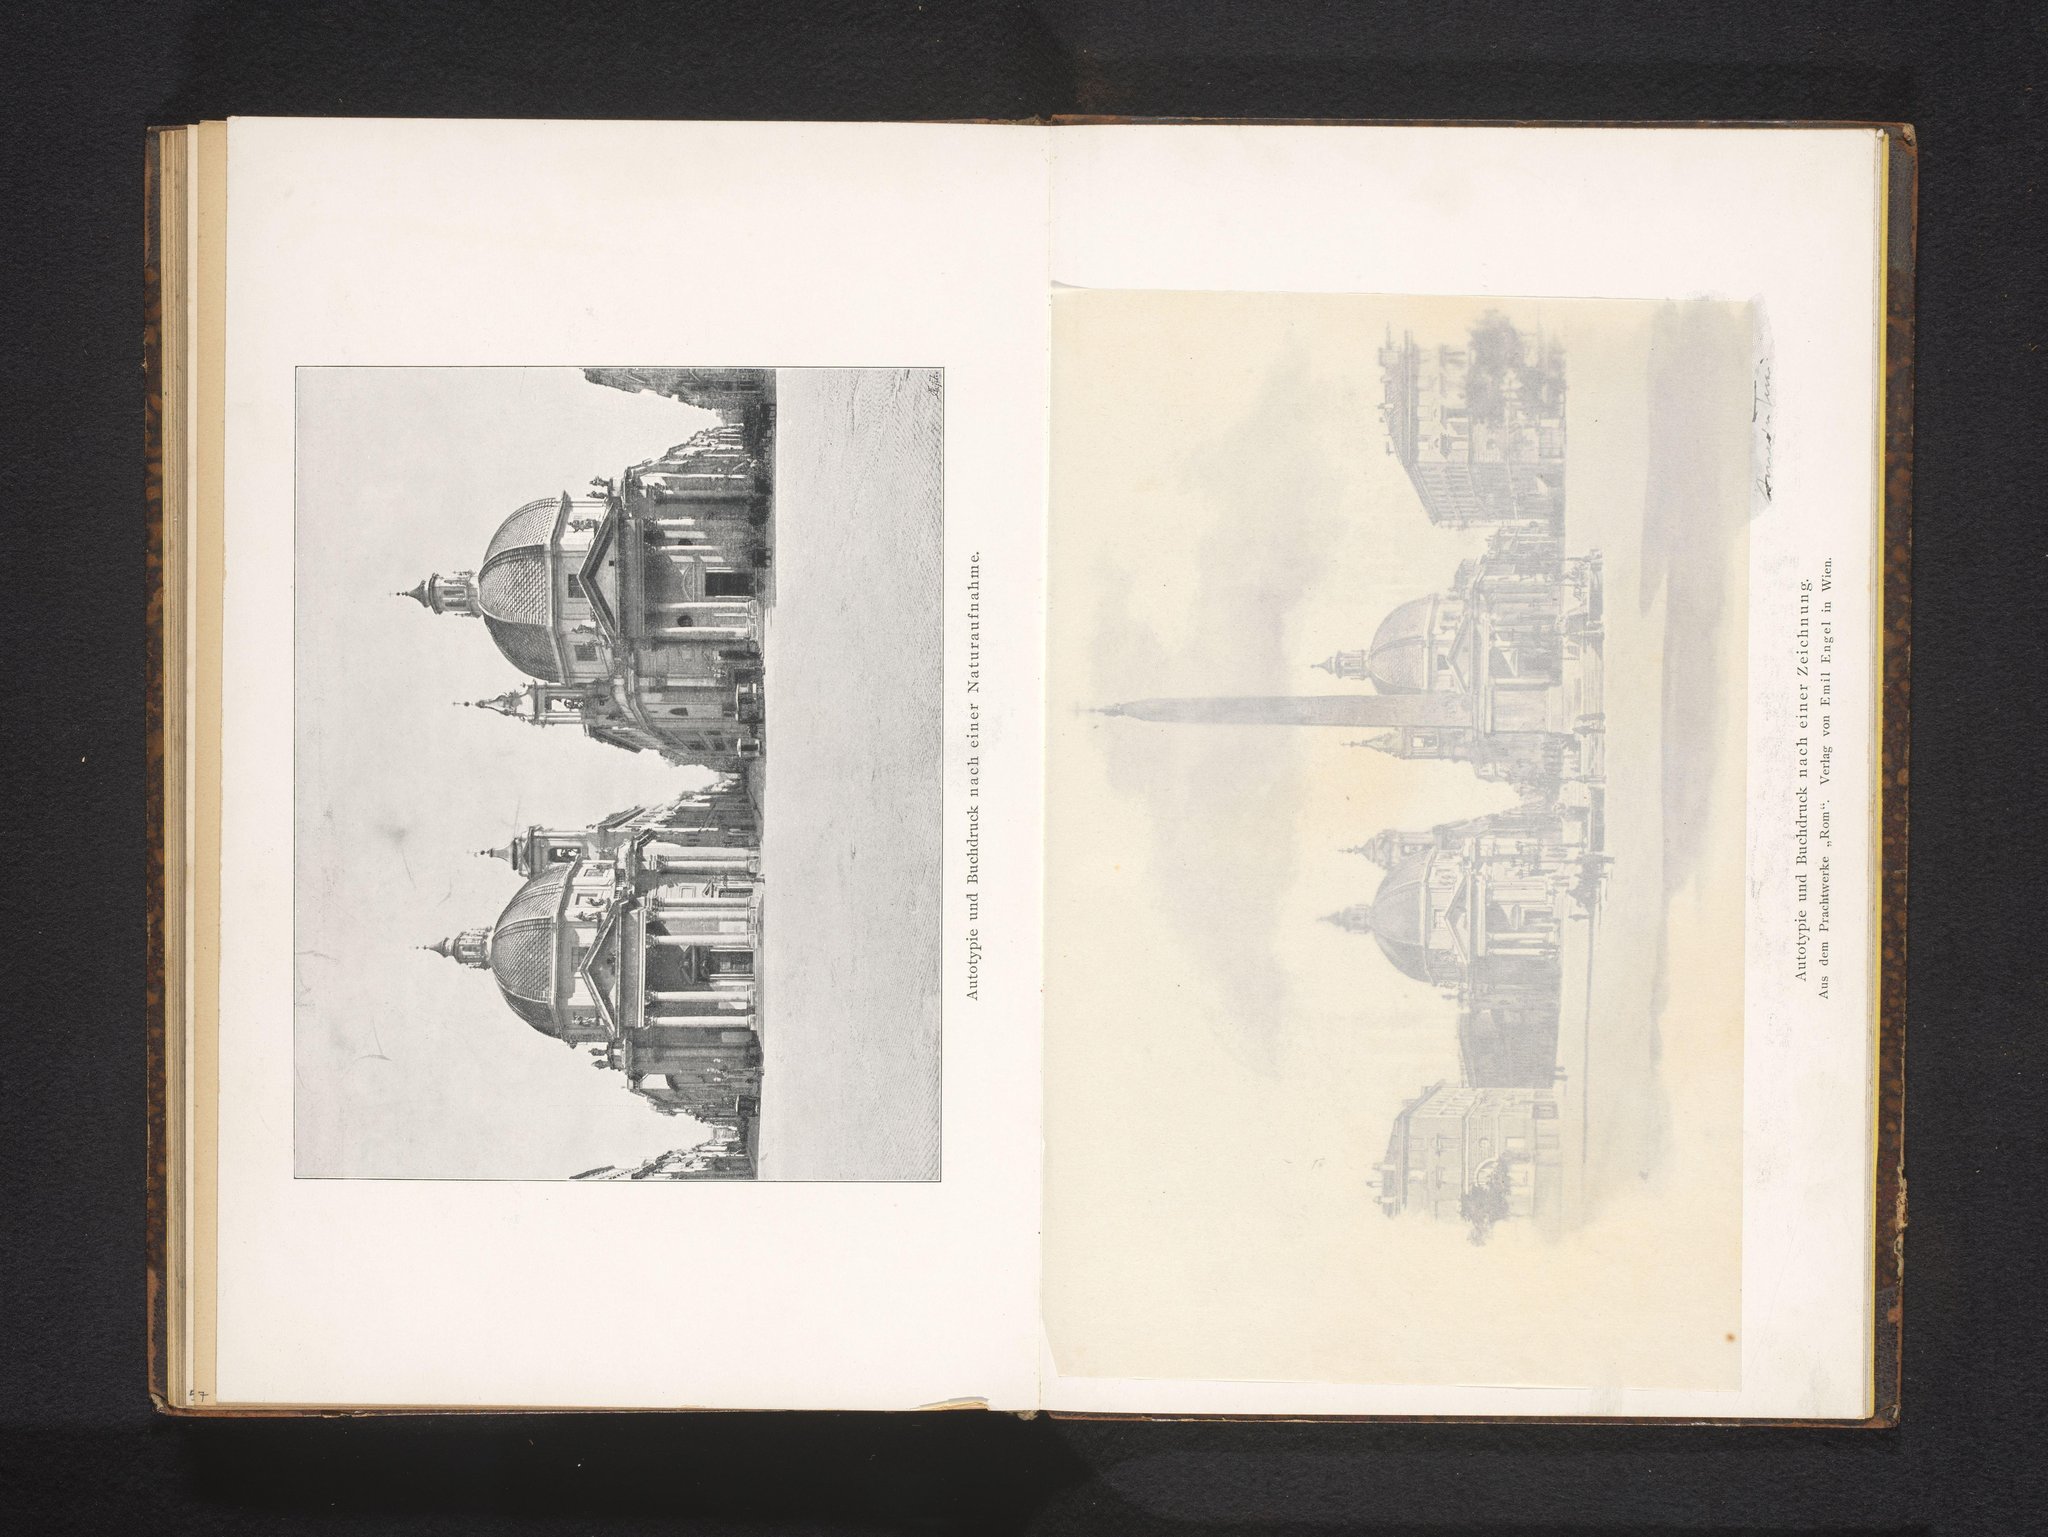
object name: page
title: Gezicht op de Santa Maria di Montesanto en de Santa Maria dei Miracoli op het Piazza del Popolo in Rome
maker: Anonymous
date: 1888-1898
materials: paper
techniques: autotype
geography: rome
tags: church (exterior)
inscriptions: inscription: ‘Autotypie und Buckdruck nach einer Naturaufnahme.’